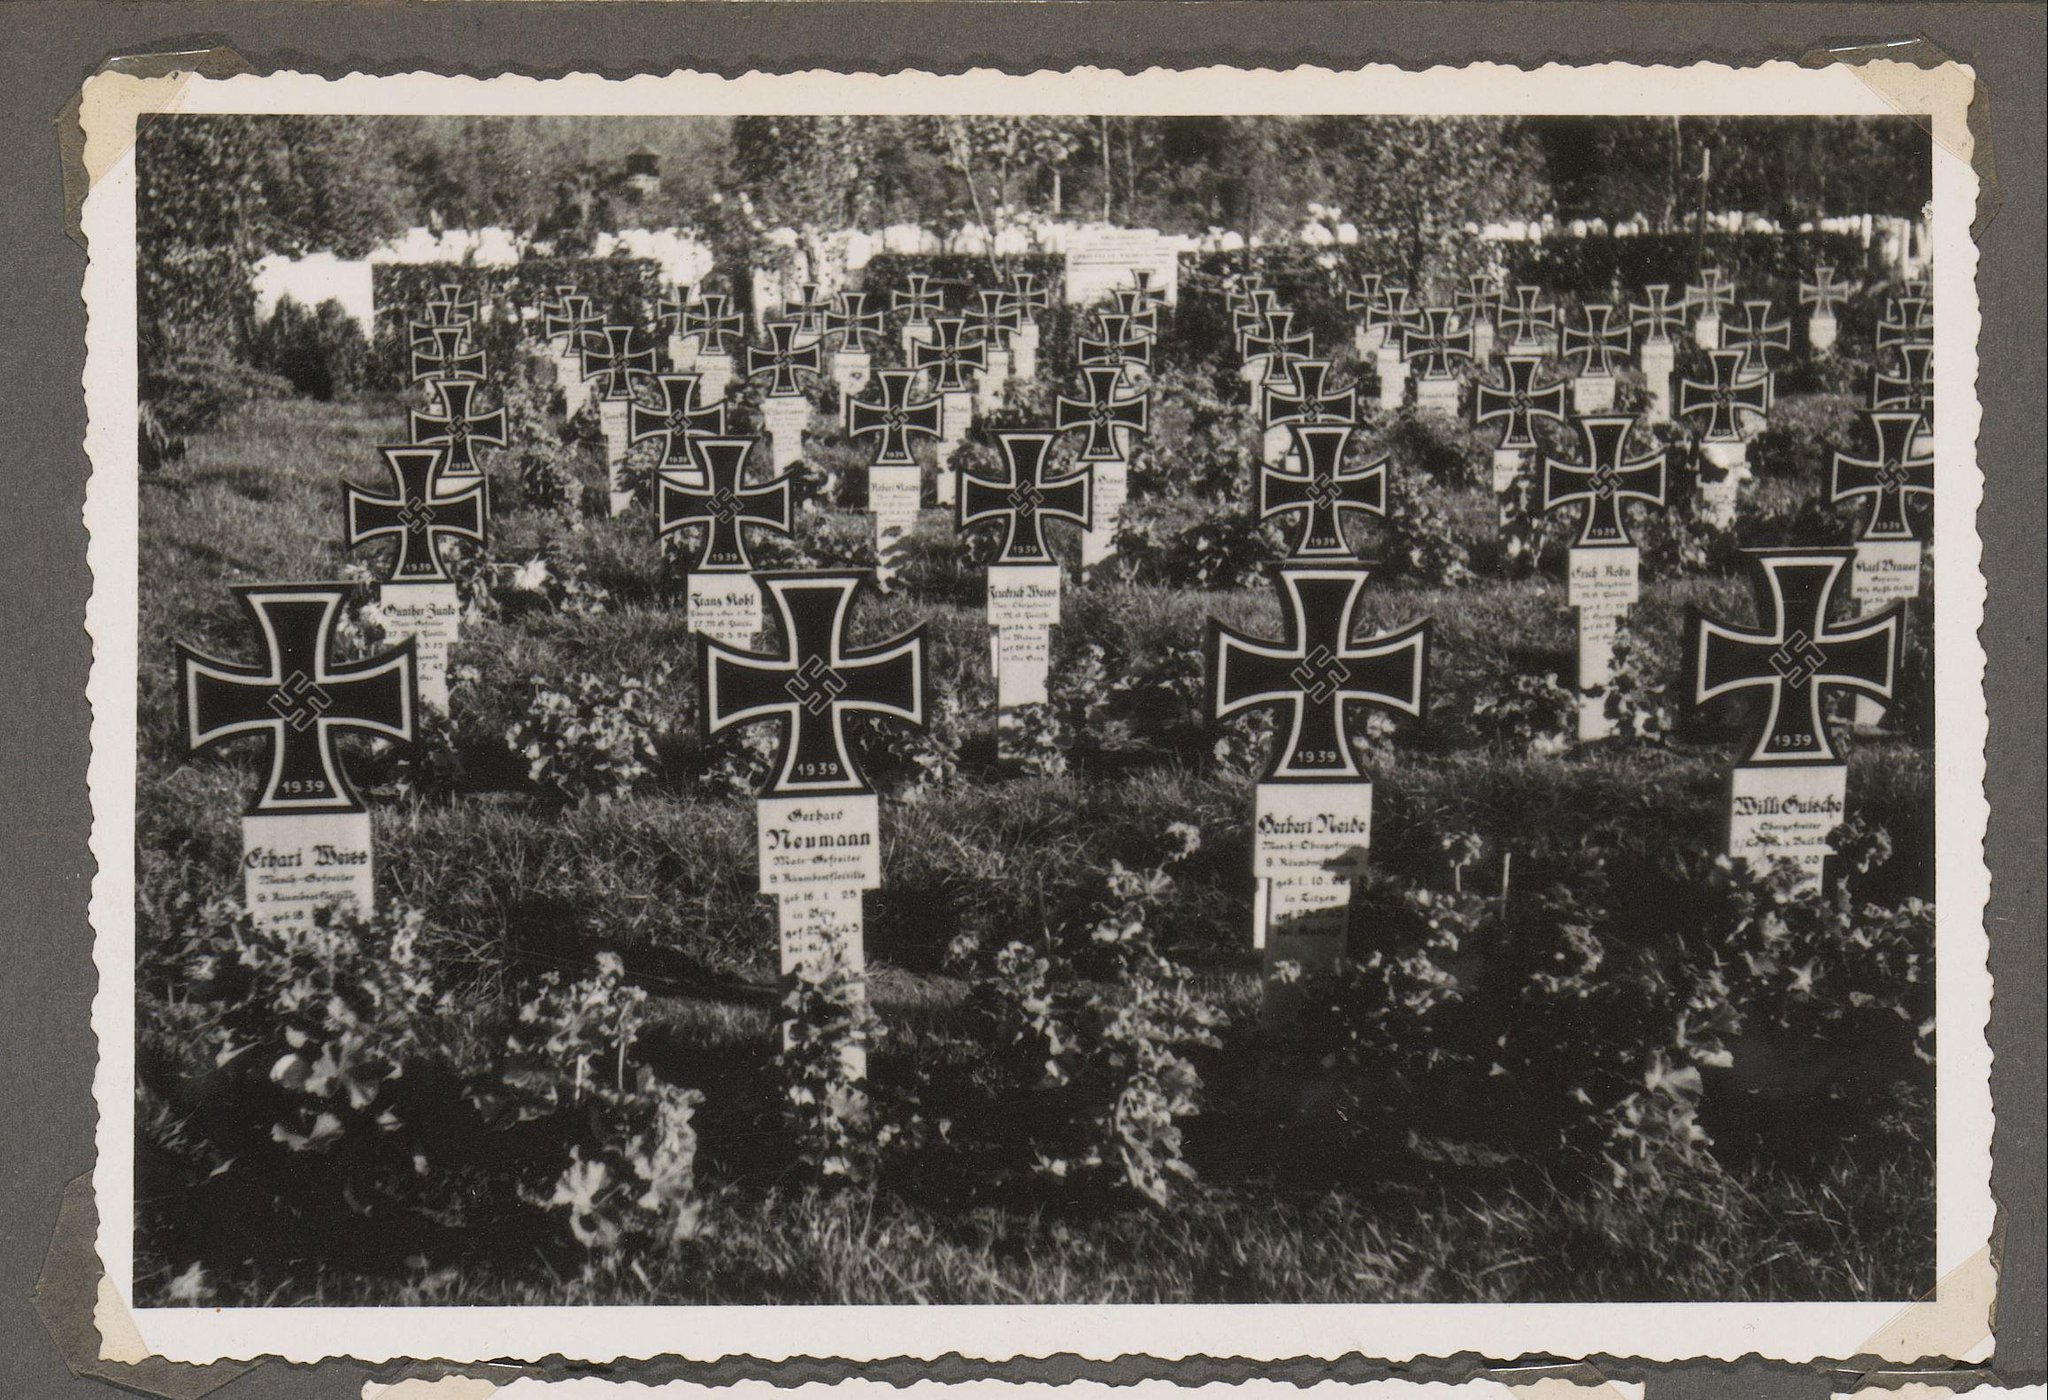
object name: photograph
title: Graven van gevallen Duitse soldaten van de Kriegsmarine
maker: Anonymous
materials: paper, photographic support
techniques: gelatin silver print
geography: netherlands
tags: grave, tomb, cemetery, park-like burying ground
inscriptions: annotation: ‘Die Gefallenen von "R103" beim S-bootsgefecht am 21 7 1943 vor Katwijk (Holland)’